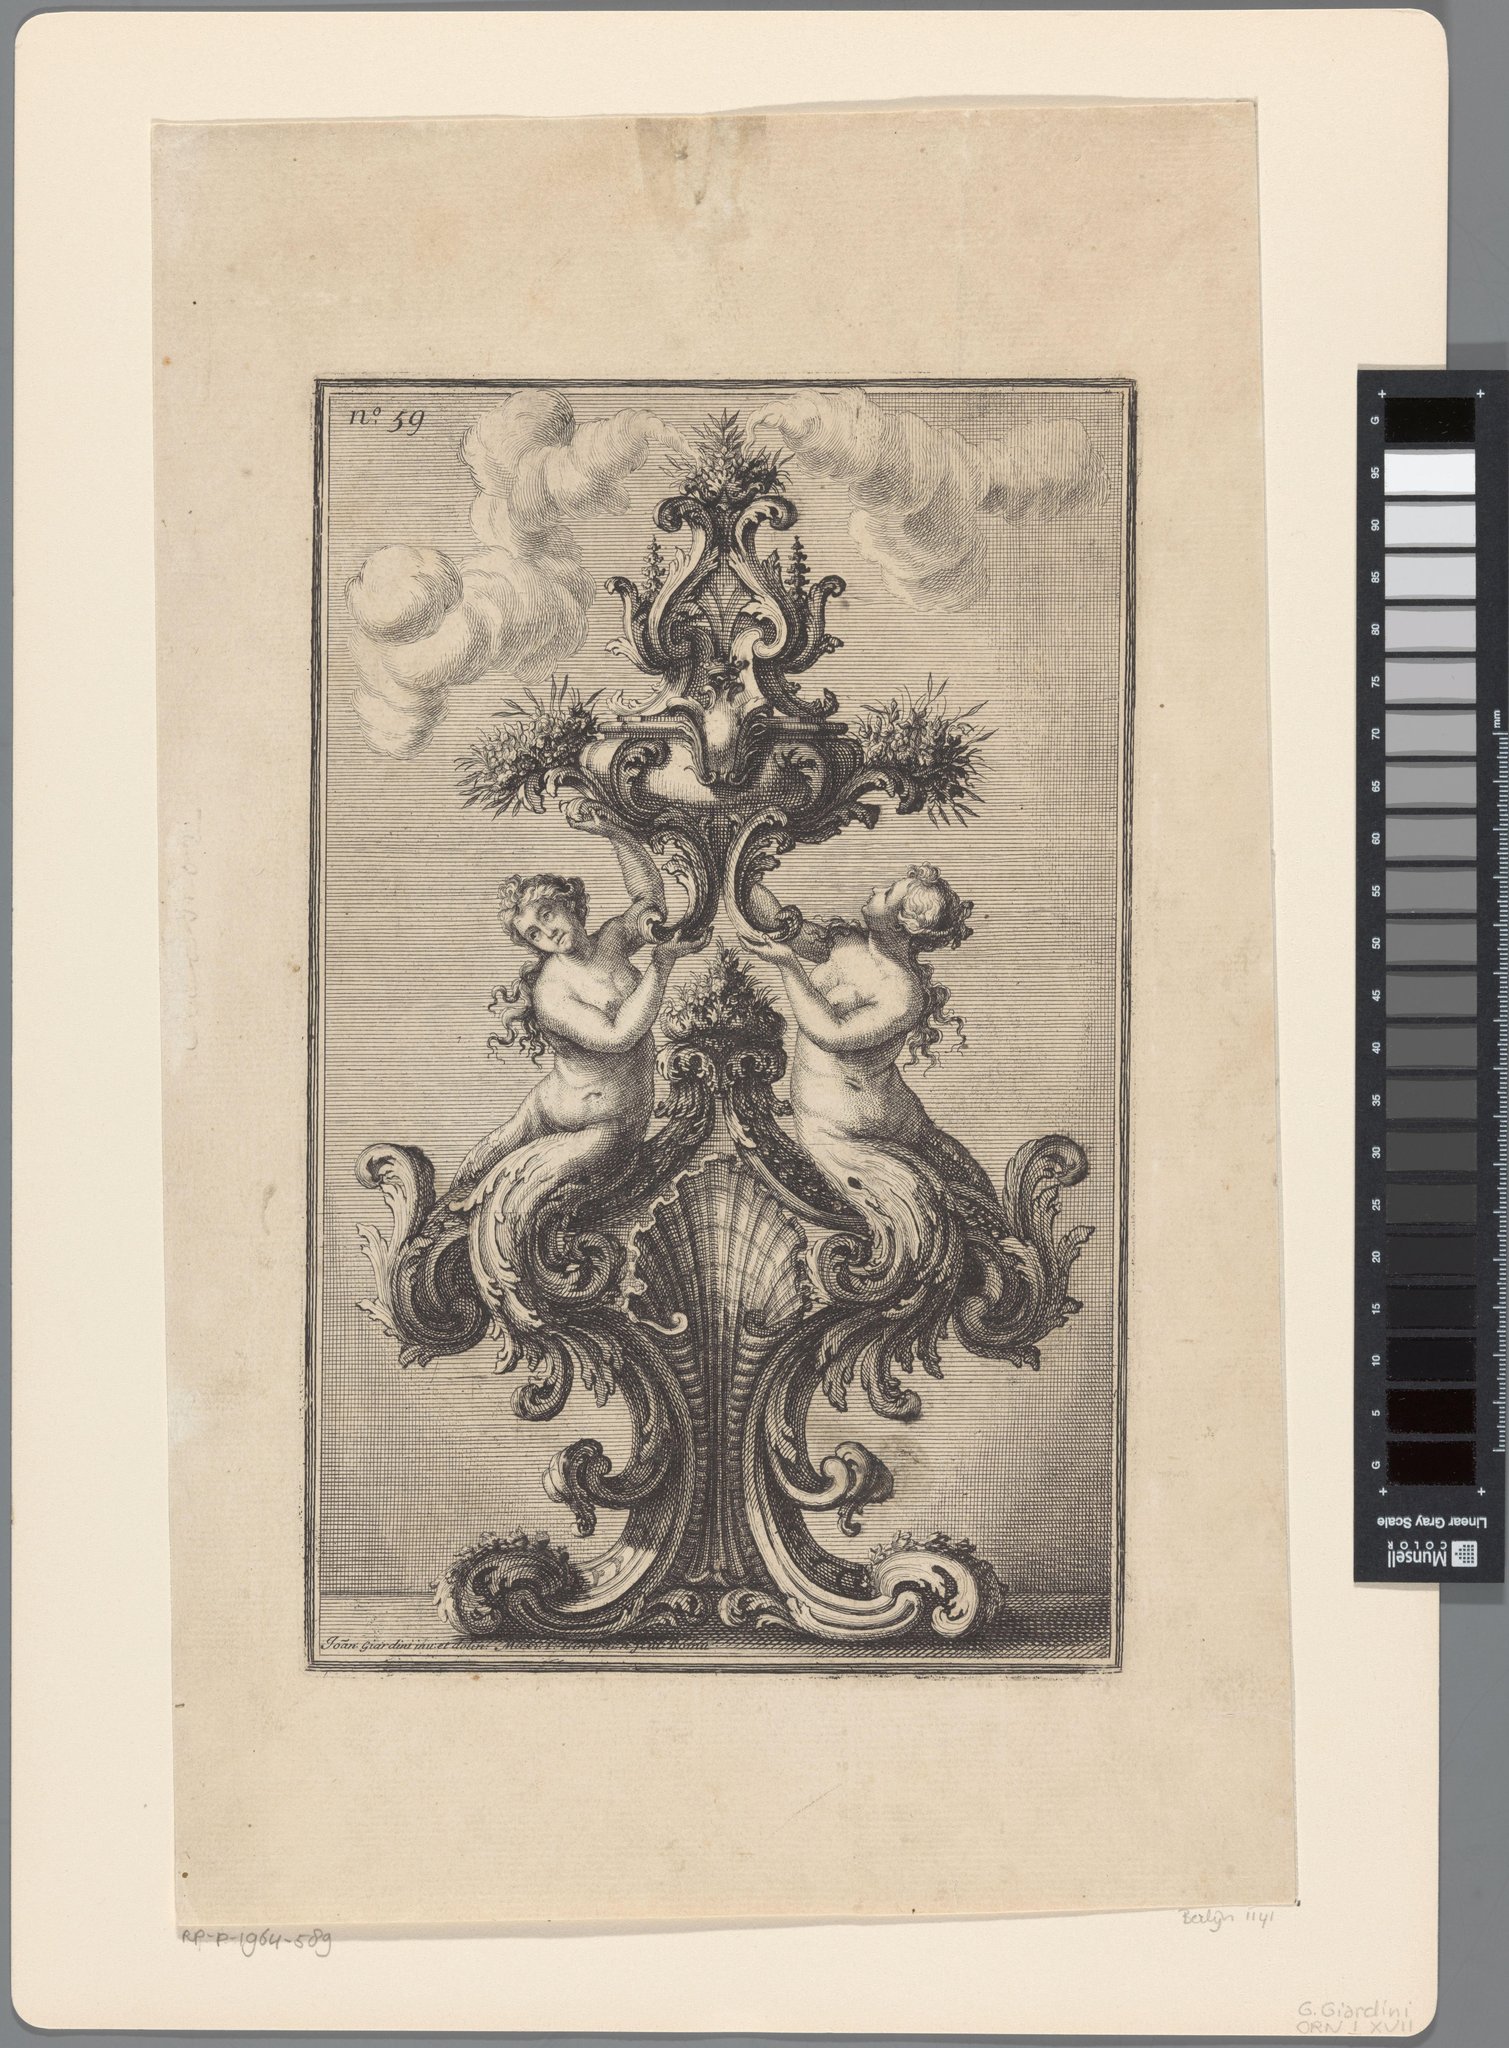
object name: print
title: Disegni diversi inventati e delineati da Giovanni Giardini da Forlì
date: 1714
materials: paper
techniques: etching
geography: italy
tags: foliage ~ ornament, censer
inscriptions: collector's mark: Lugt 2228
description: Prent maakt deel uit van een reeks van 100 ornamentprenten naar ontwerp van Giovanni Giardini.